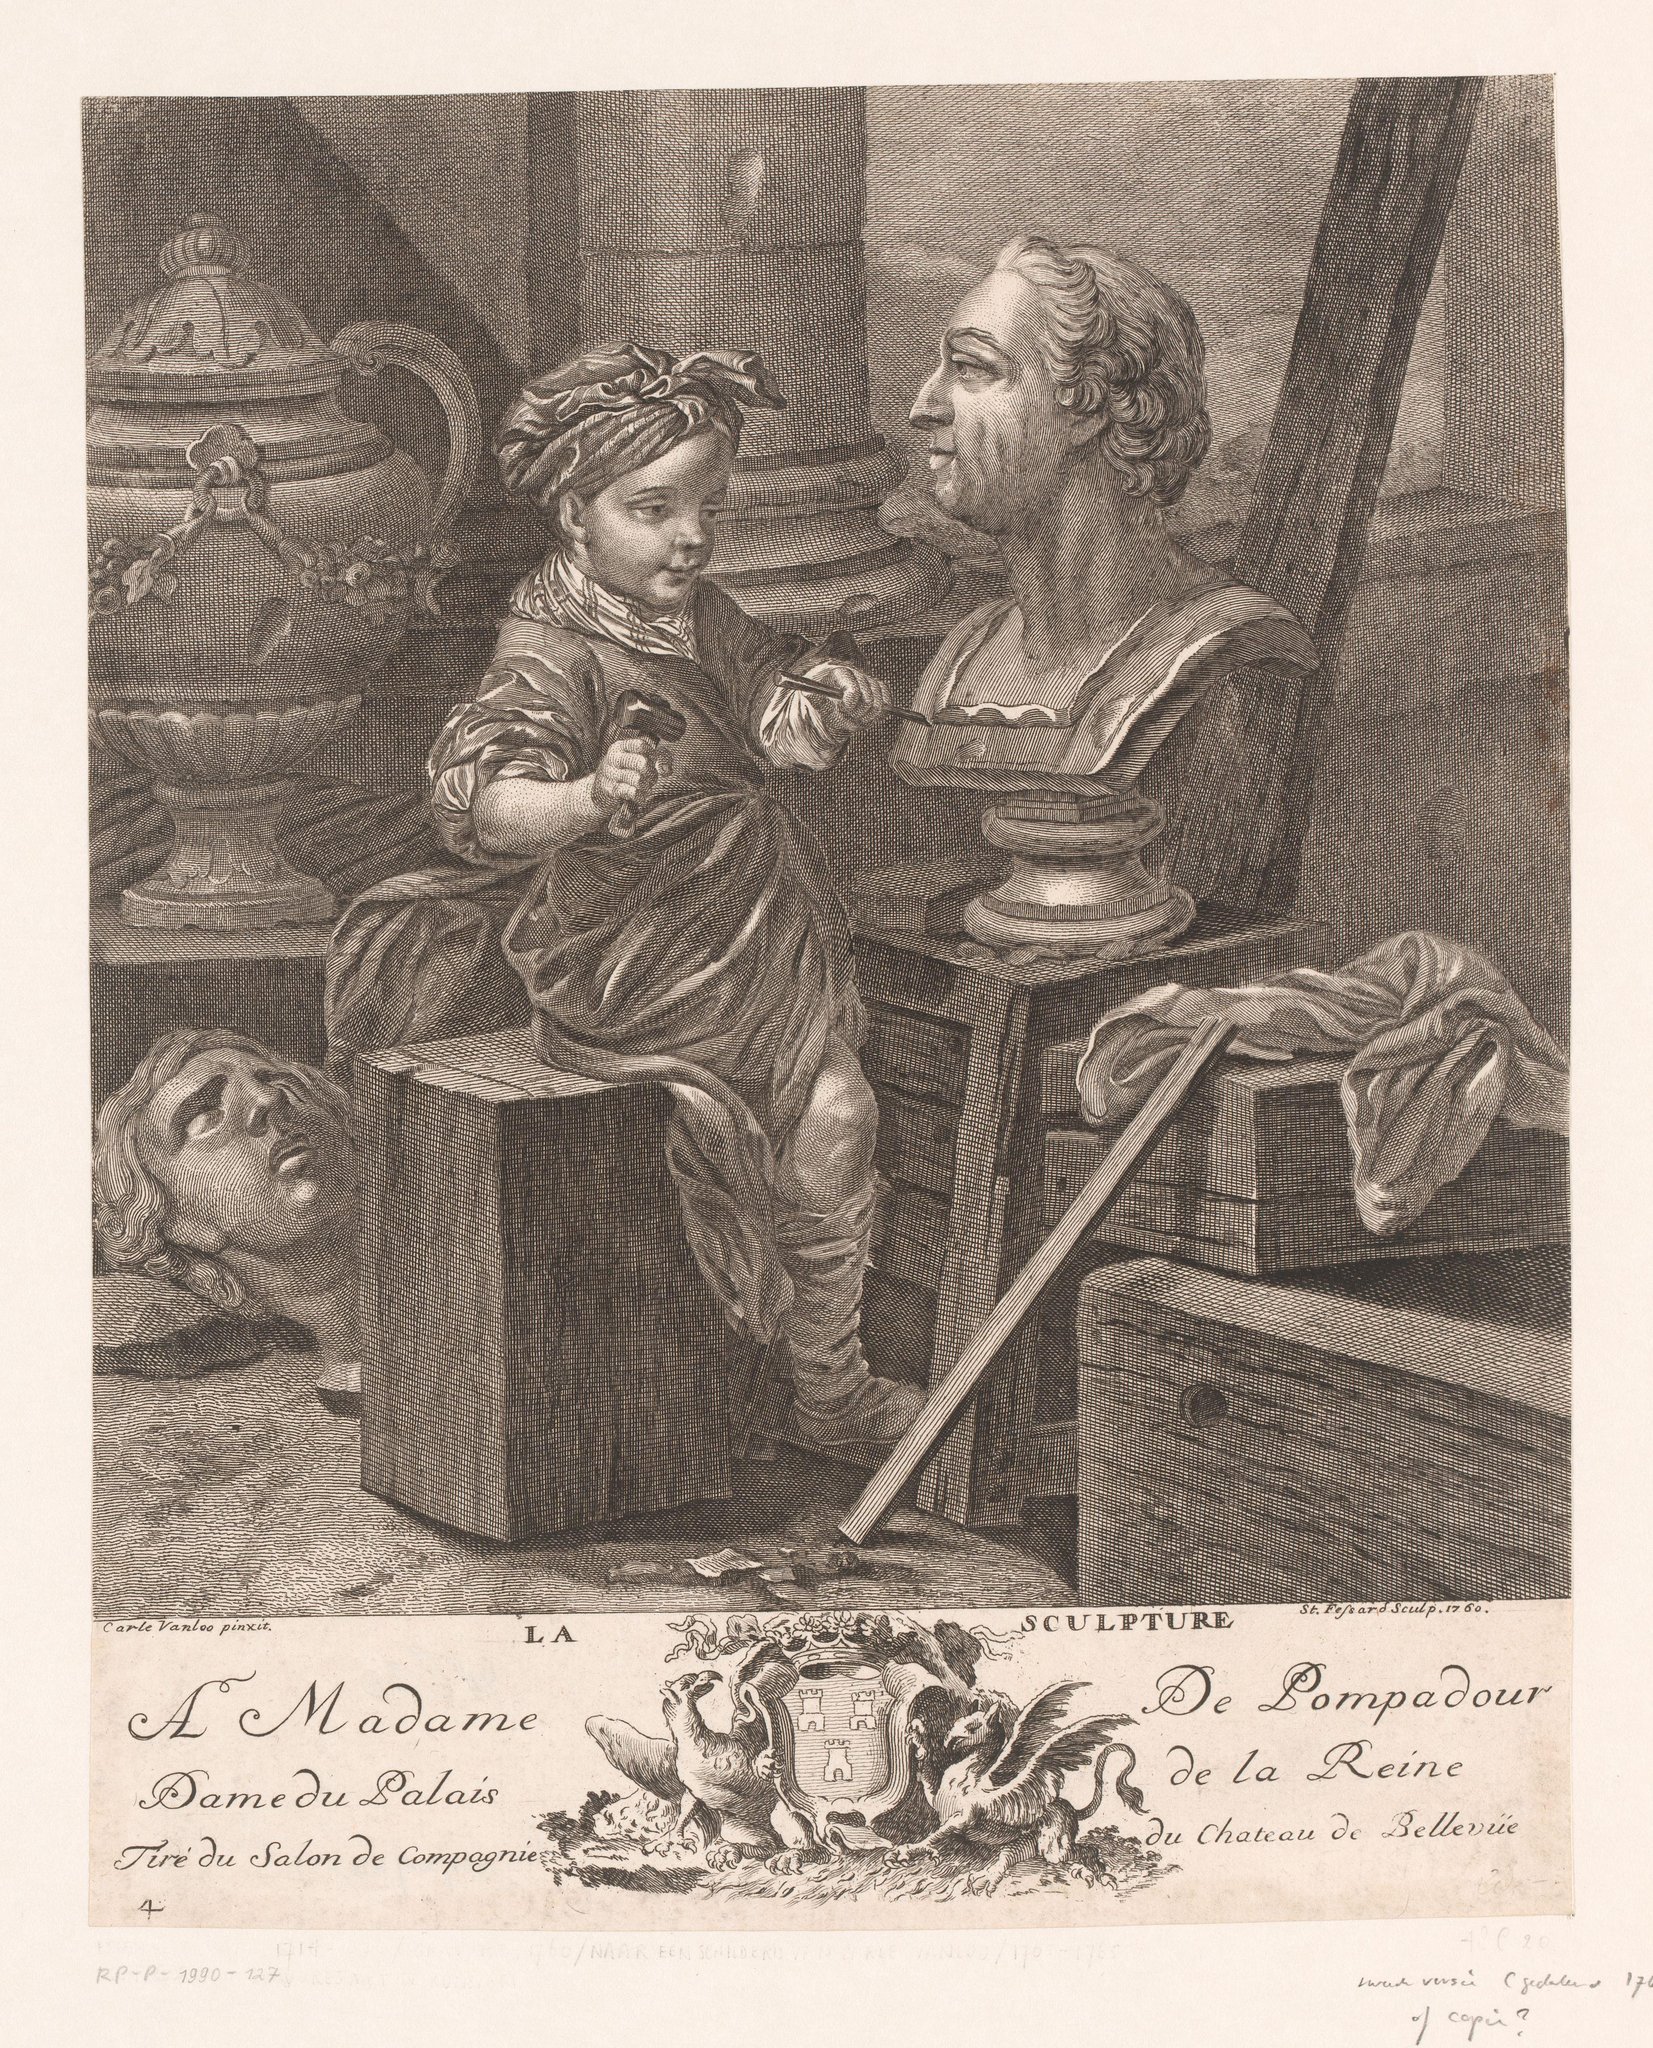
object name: print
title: Personificatie van de beeldhouwkunst met een buste van Lodewijk XV van Frankrijk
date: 1760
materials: paper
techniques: engraving, etching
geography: france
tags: louis xv of france, 'sculptura', symbolic representations, allegories and emblems ~ sculpture; 'scoltura' (ripa), children behaving like adults, armorial bearing, heraldry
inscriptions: collector's mark: Lugt 2228